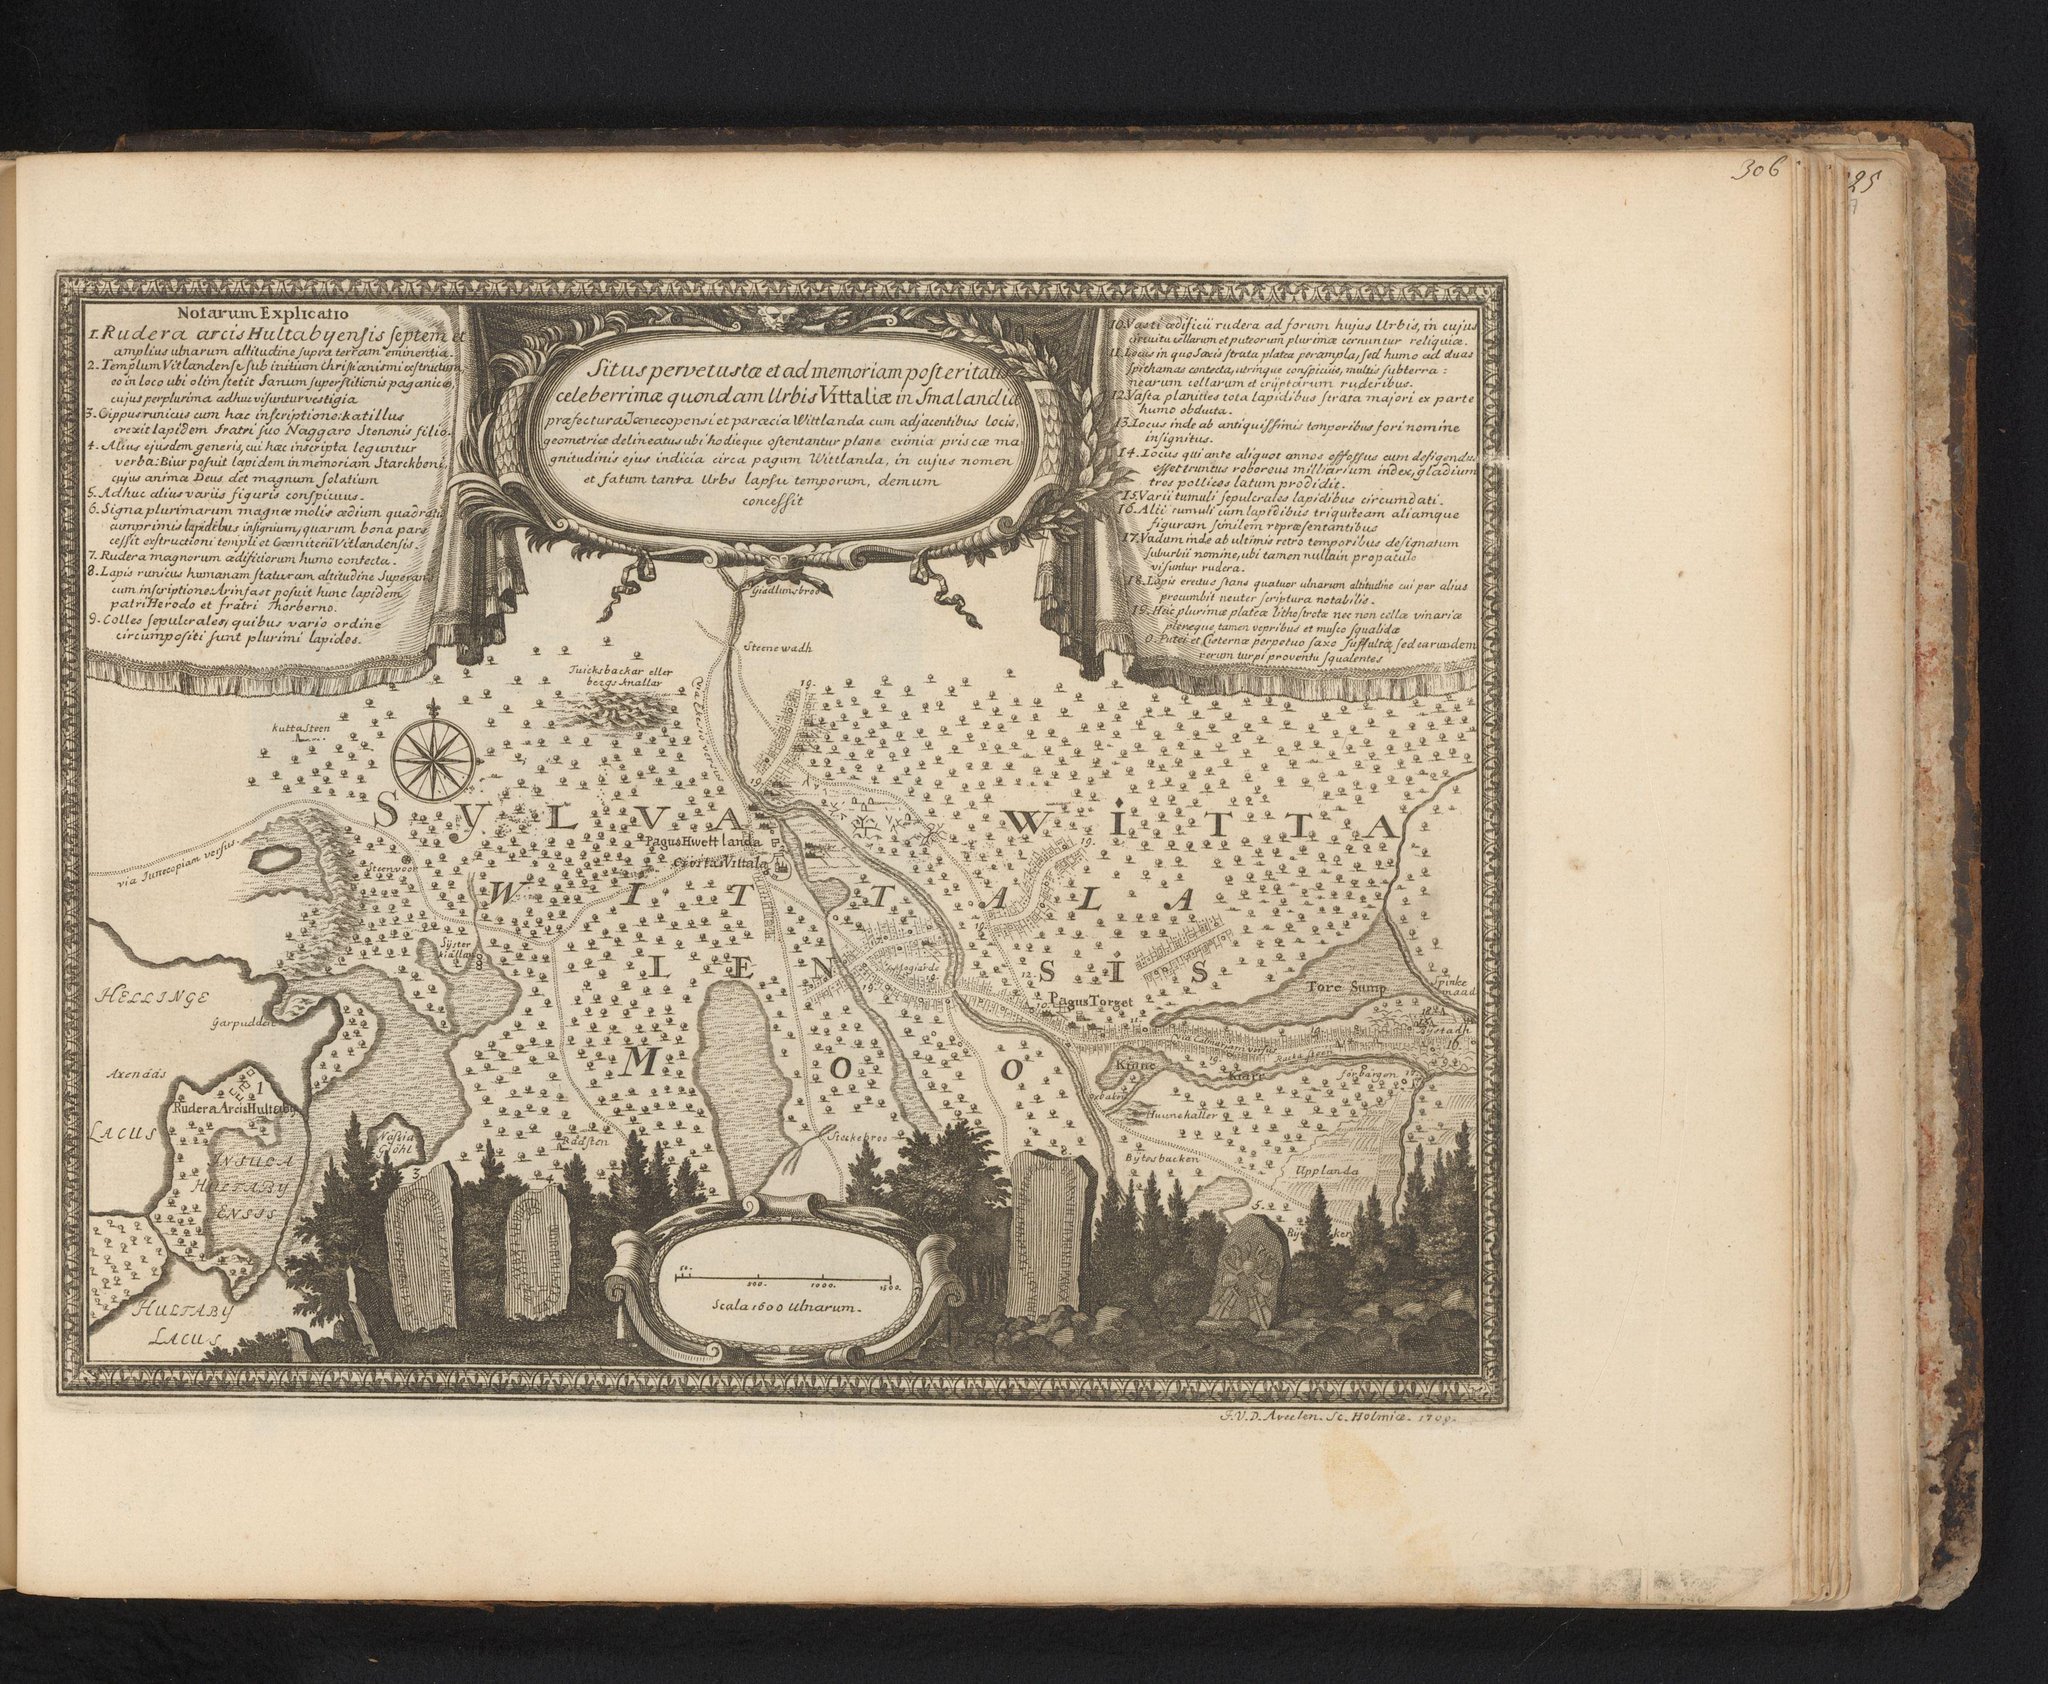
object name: print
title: Suecia Antiqua et Hodierna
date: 1708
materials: paper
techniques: etching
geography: stockholm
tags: maps of separate countries or regions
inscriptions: date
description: Kungliga Biblioteket, 'Suecia': http://www.kb.se/samlingarna/Kartor-bilder/Suecia-antiqua/ (geraadpleegd november 2016).